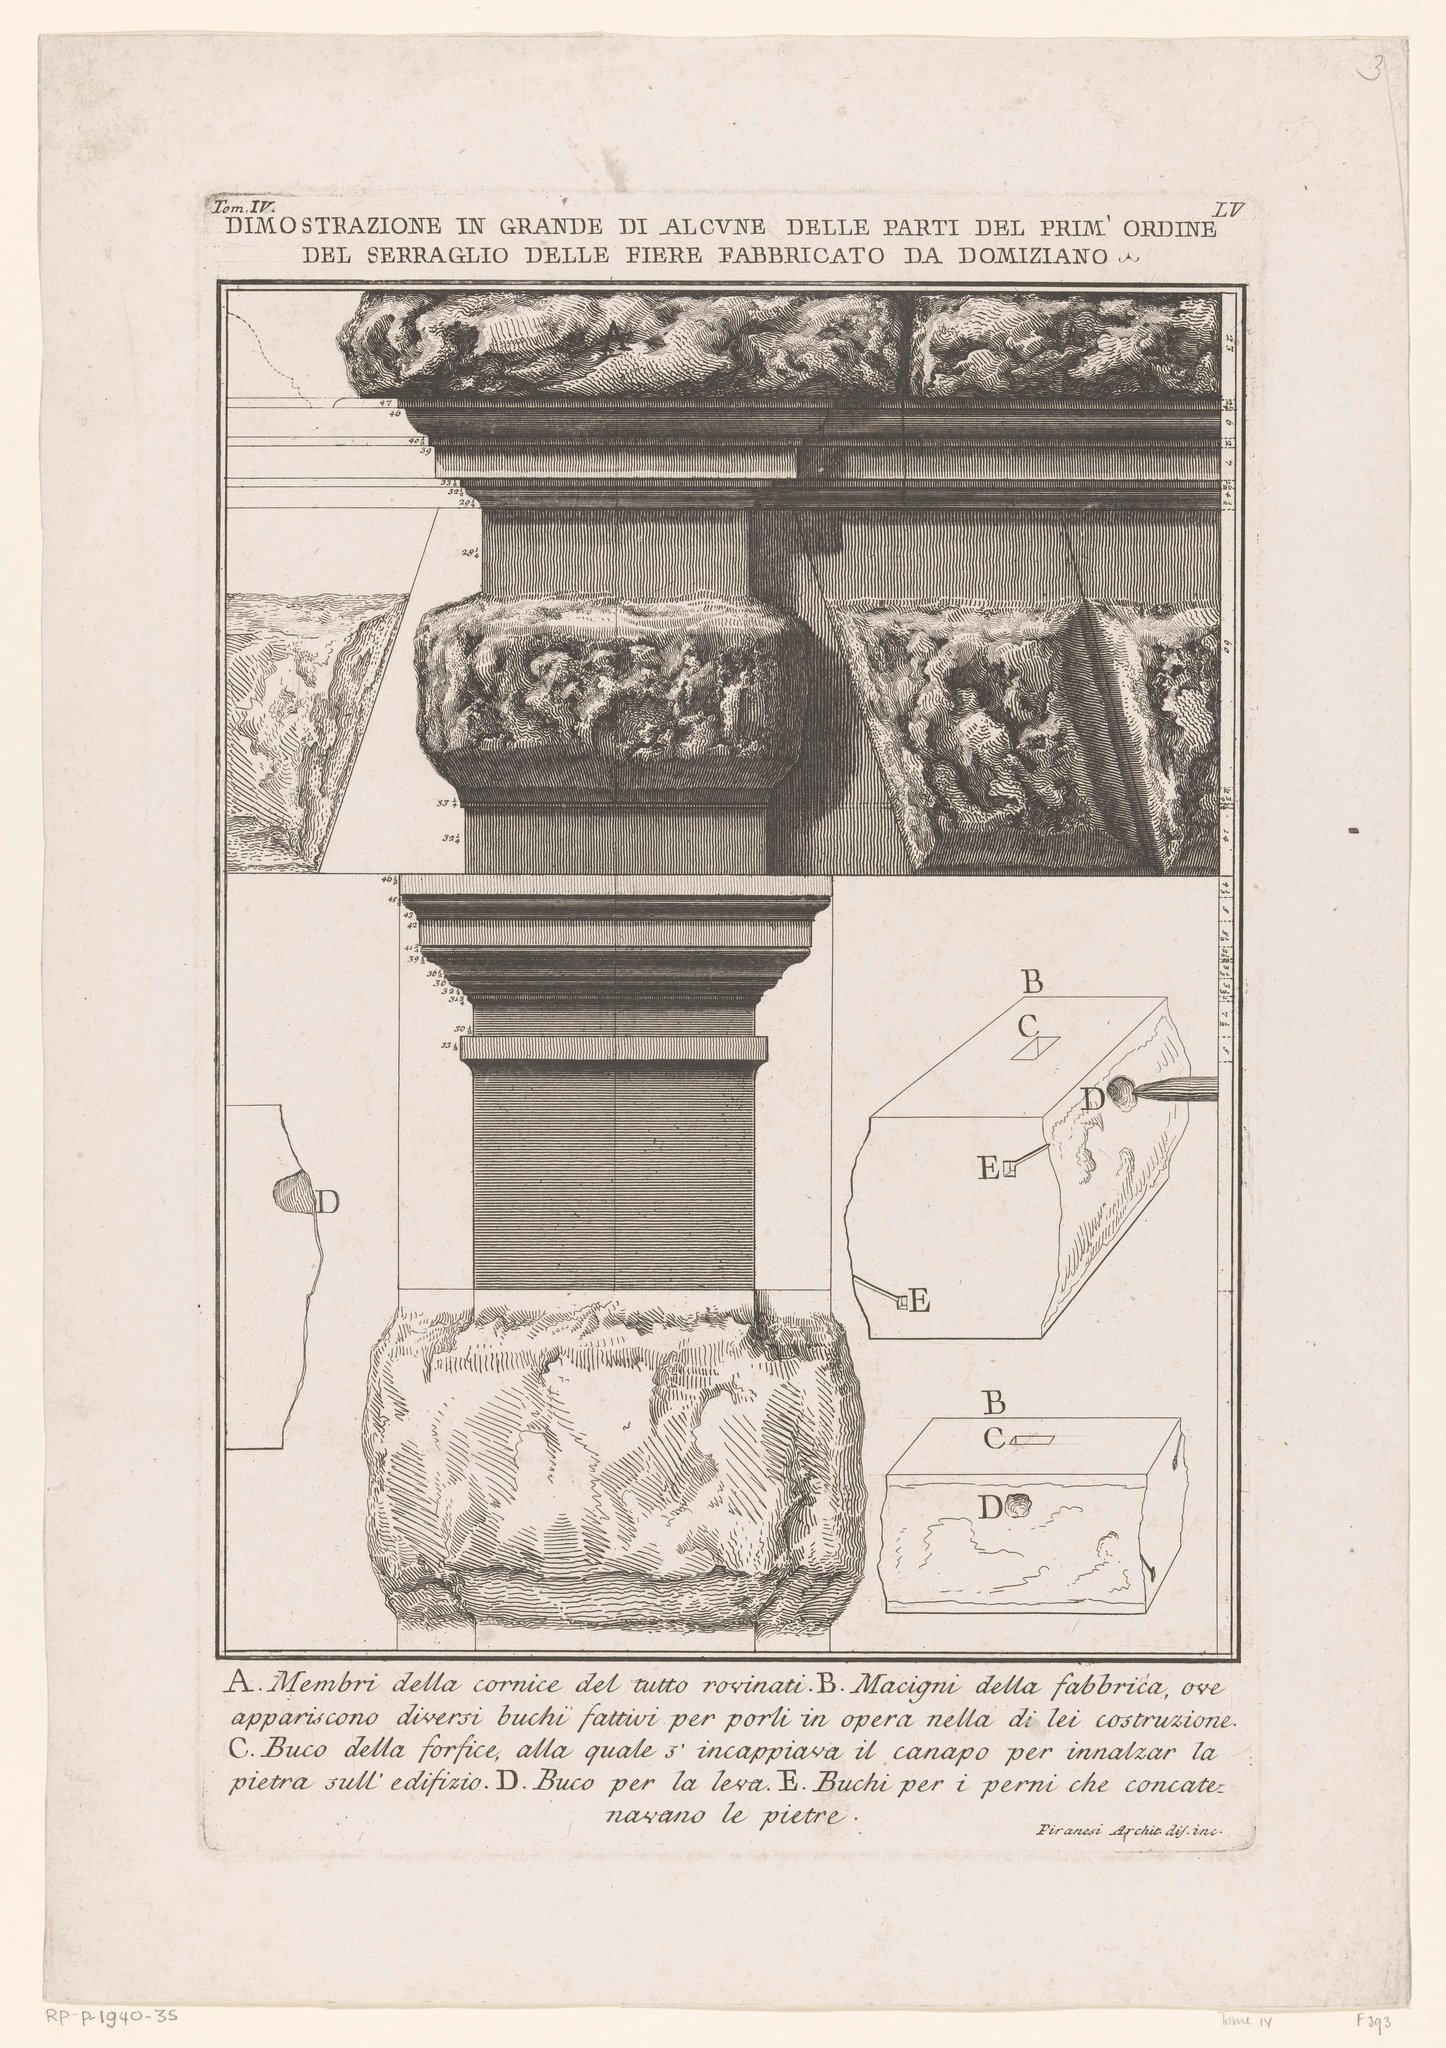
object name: print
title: Le Antichità Romane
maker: giovanni battista piranesi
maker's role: designer, draughtsman, print maker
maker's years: 1720-1778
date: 1756-1757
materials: paper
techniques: etching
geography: rome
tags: ruin of a building ~ architecture, boulder, stone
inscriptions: collector's mark: Lugt 2228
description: Deze prent maakt deel uit van de serie 'Le Antichità Romane'. Piranesi deed meer dan acht jaar voorstudie voor deze 250 platen tellende serie die in vier volumes werd uitgegeven. Hij produceerde de prenten tussen ca. 1756 en 1757. De serie bevat ook prenten door of naar andere prentmakers, onder wie Francesco Bianchini en Girolamo Rossi.